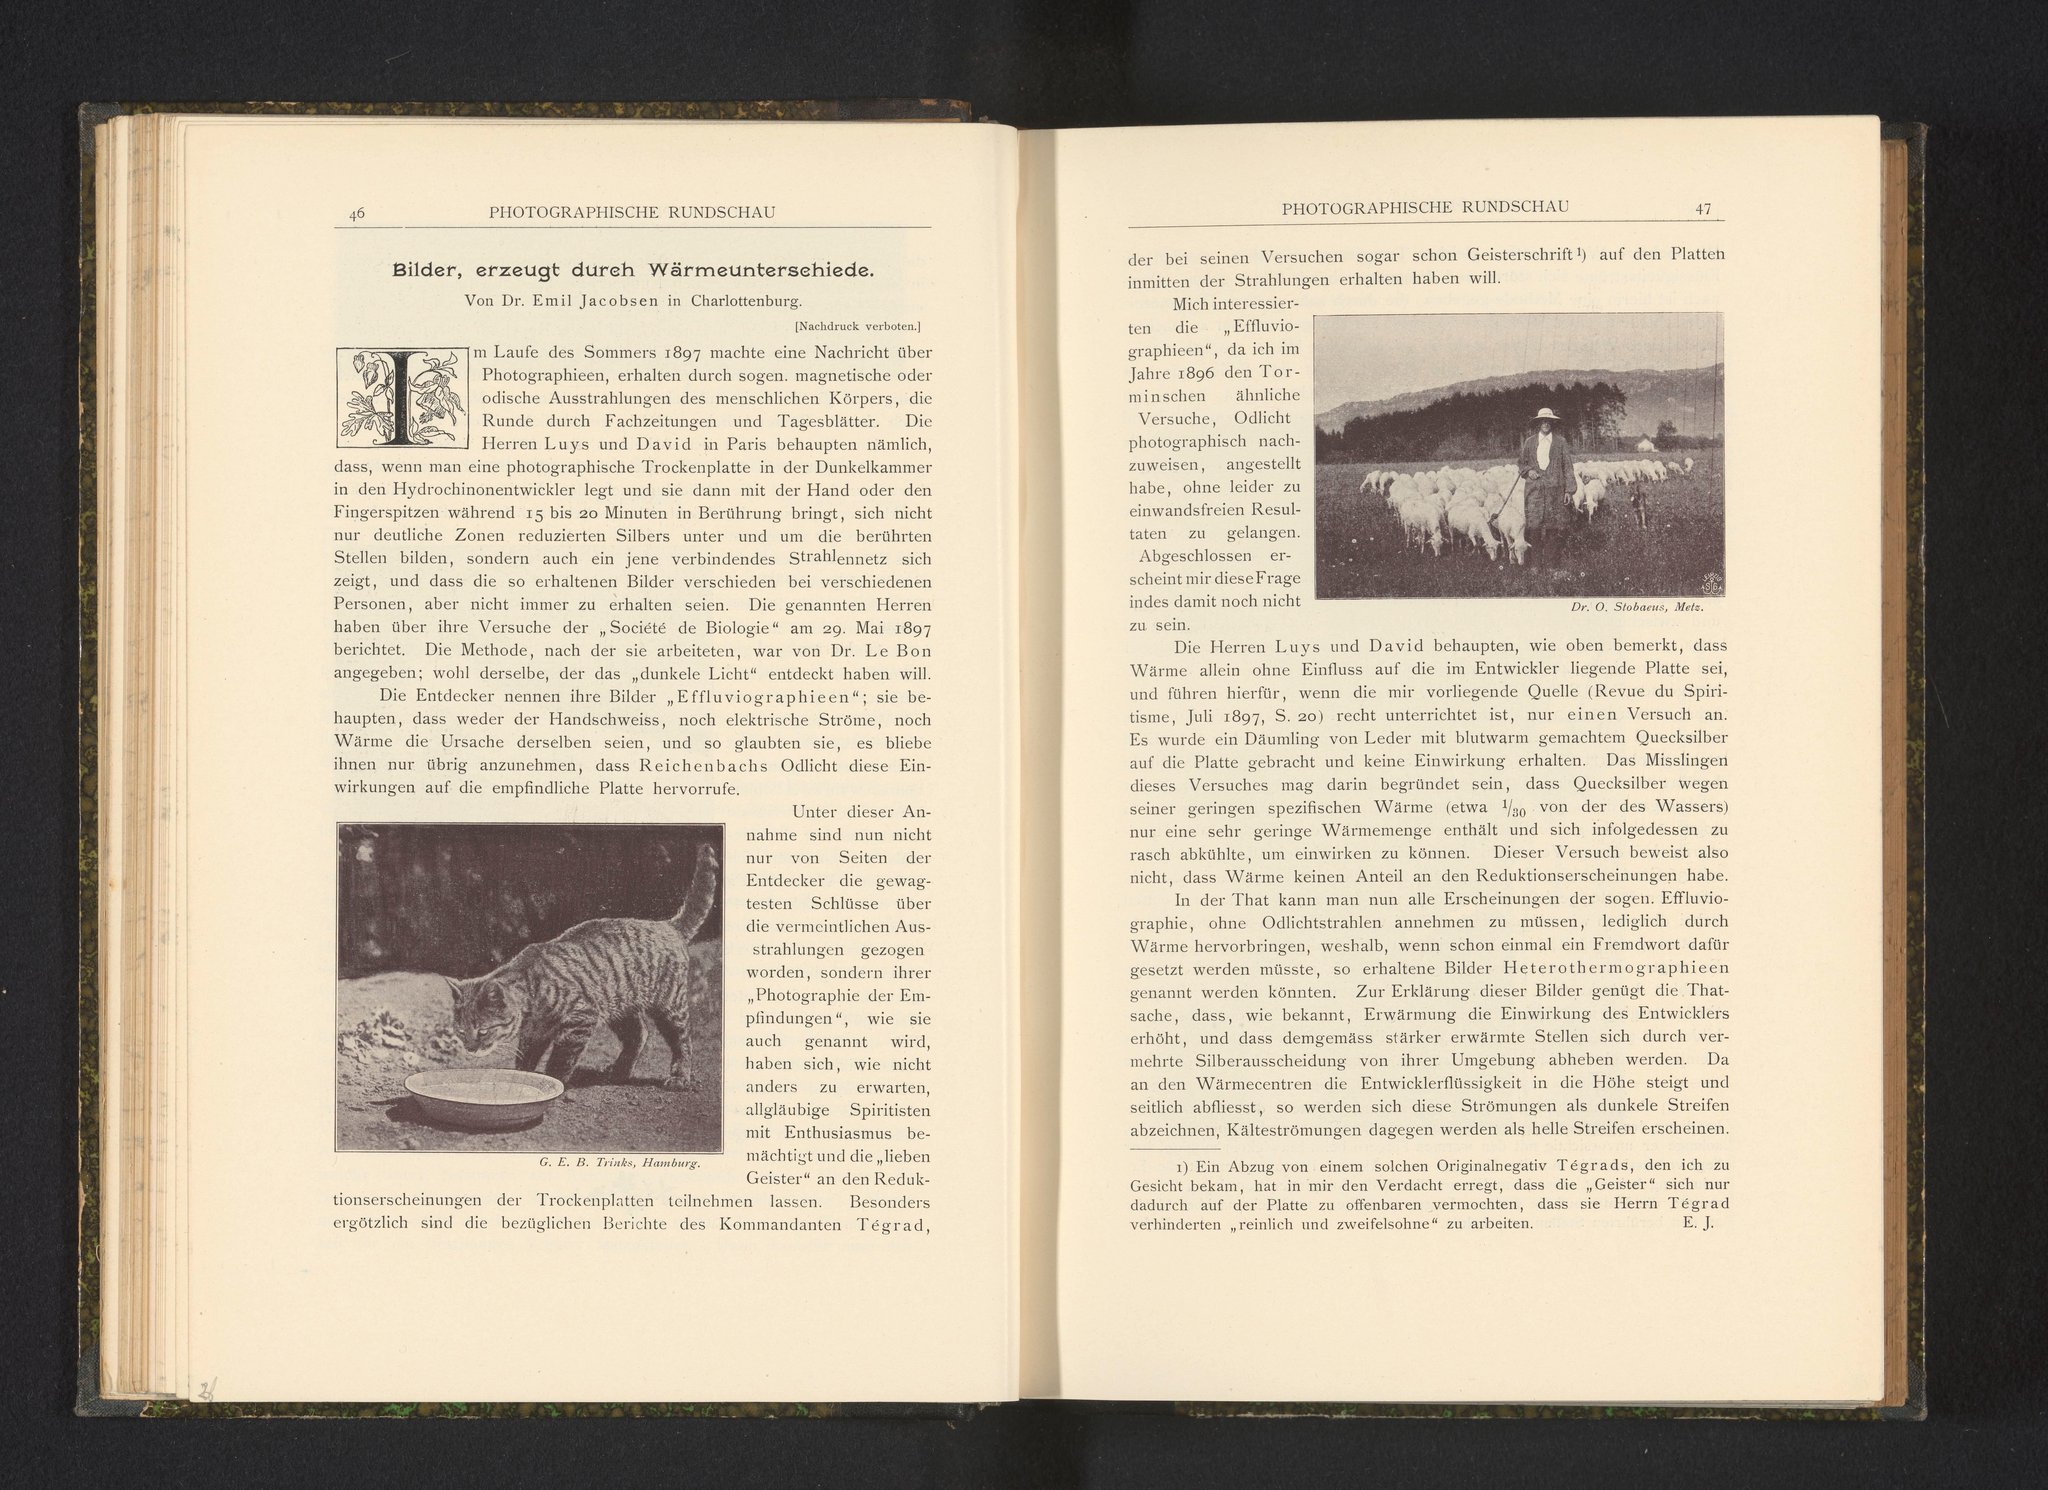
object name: photomechanical print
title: Herder met een schaapskudde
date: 1893-1898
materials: paper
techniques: autotype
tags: herding, herdsman, herdswoman, shepherd, shepherdess, cowherd, etc., herd, flock